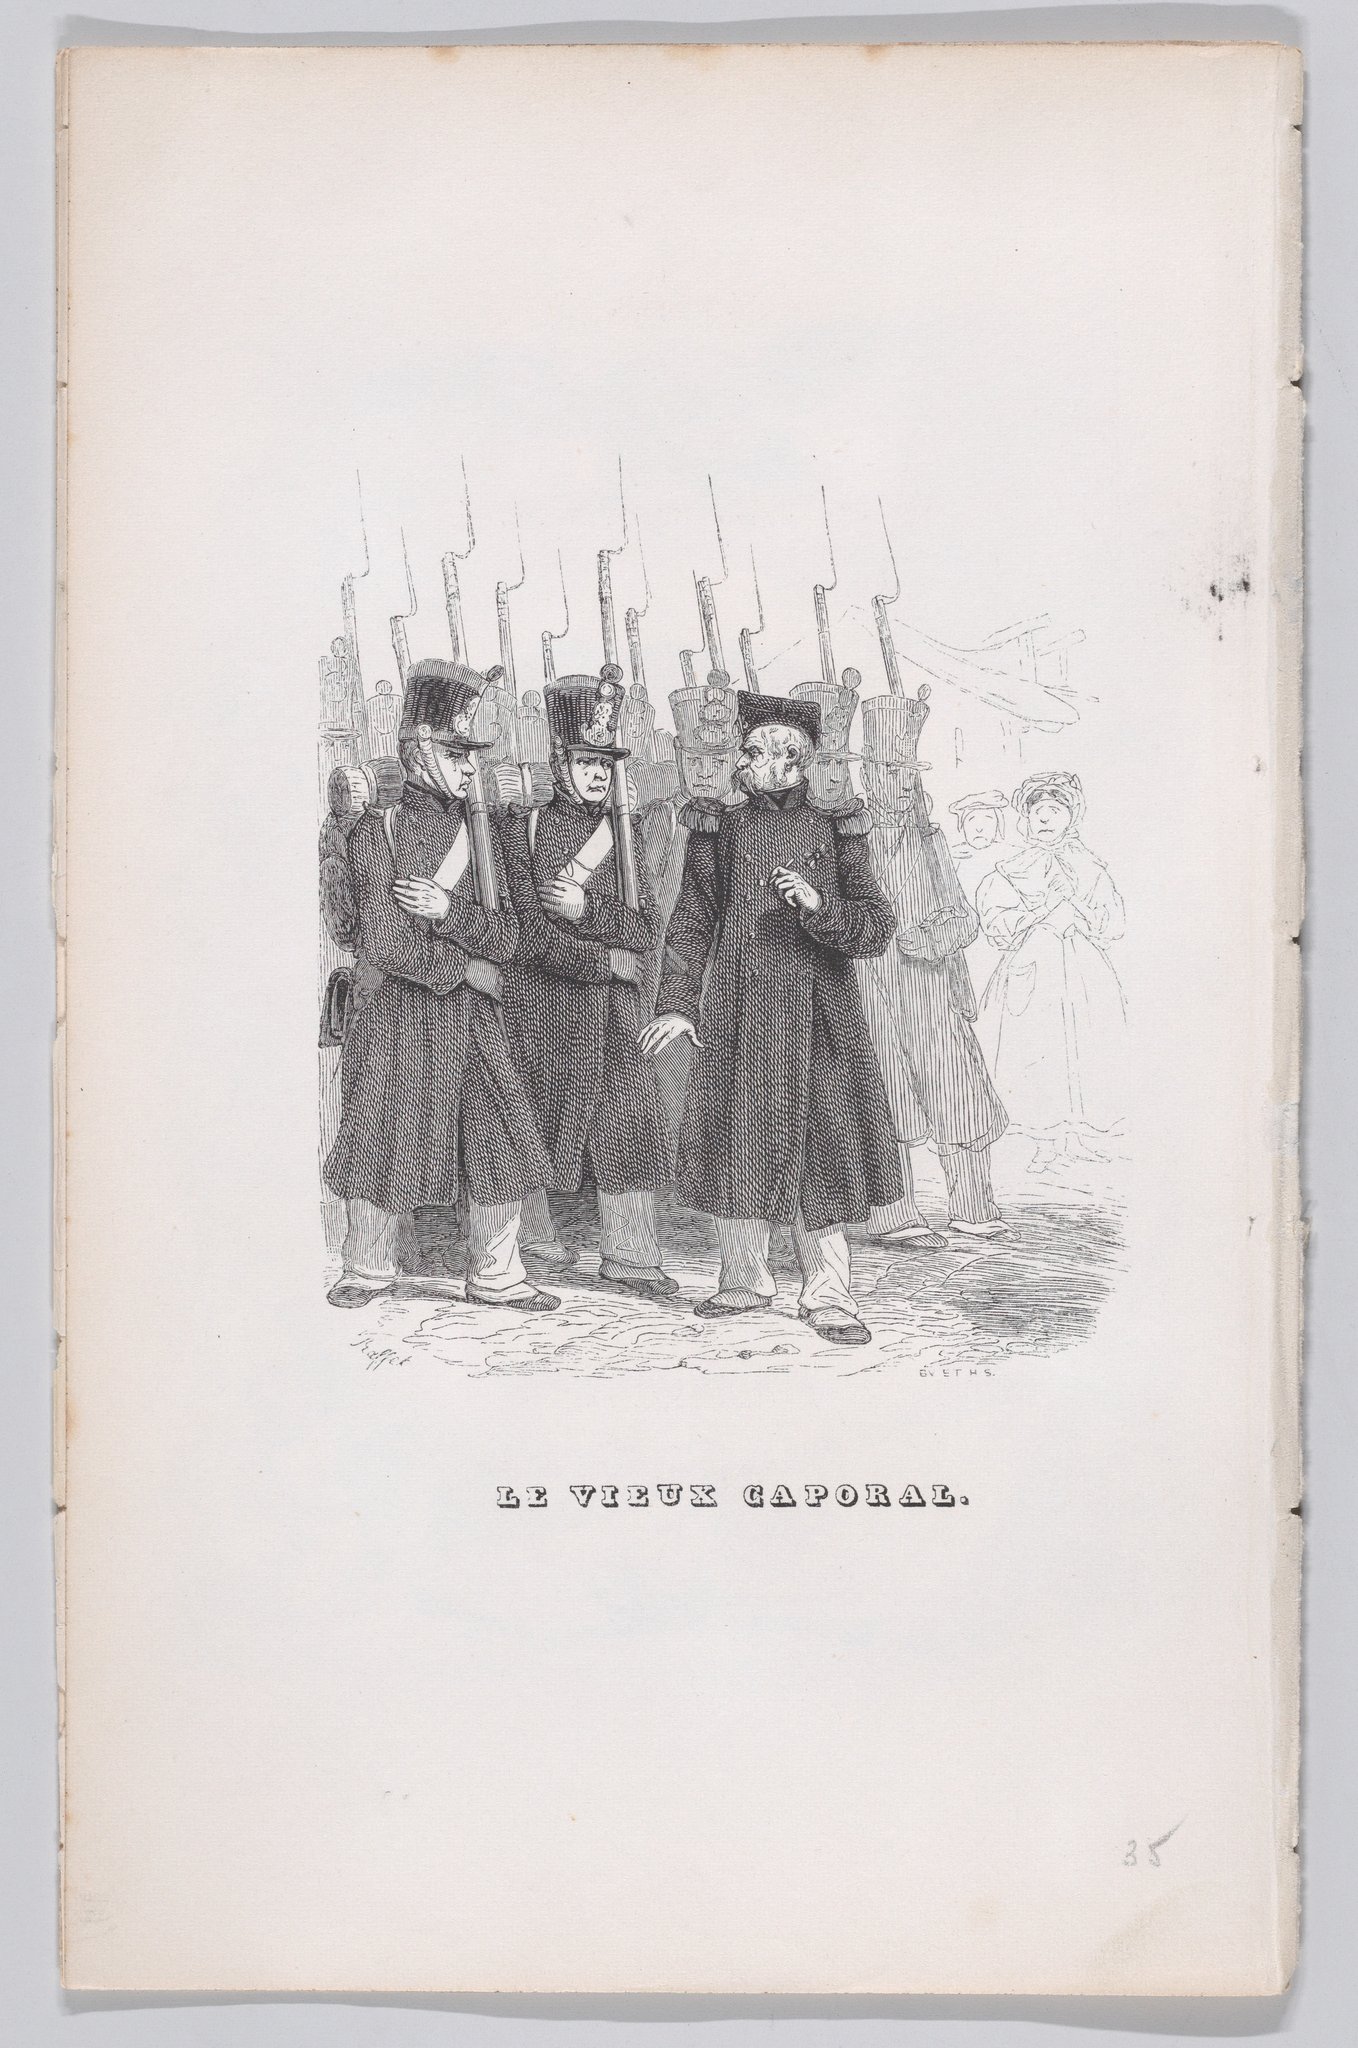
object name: print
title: The Old Corporal, from "The Complete Works of Béranger"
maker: j. j. grandville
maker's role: illustrator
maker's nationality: french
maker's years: 1803-1847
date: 1836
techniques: engraving